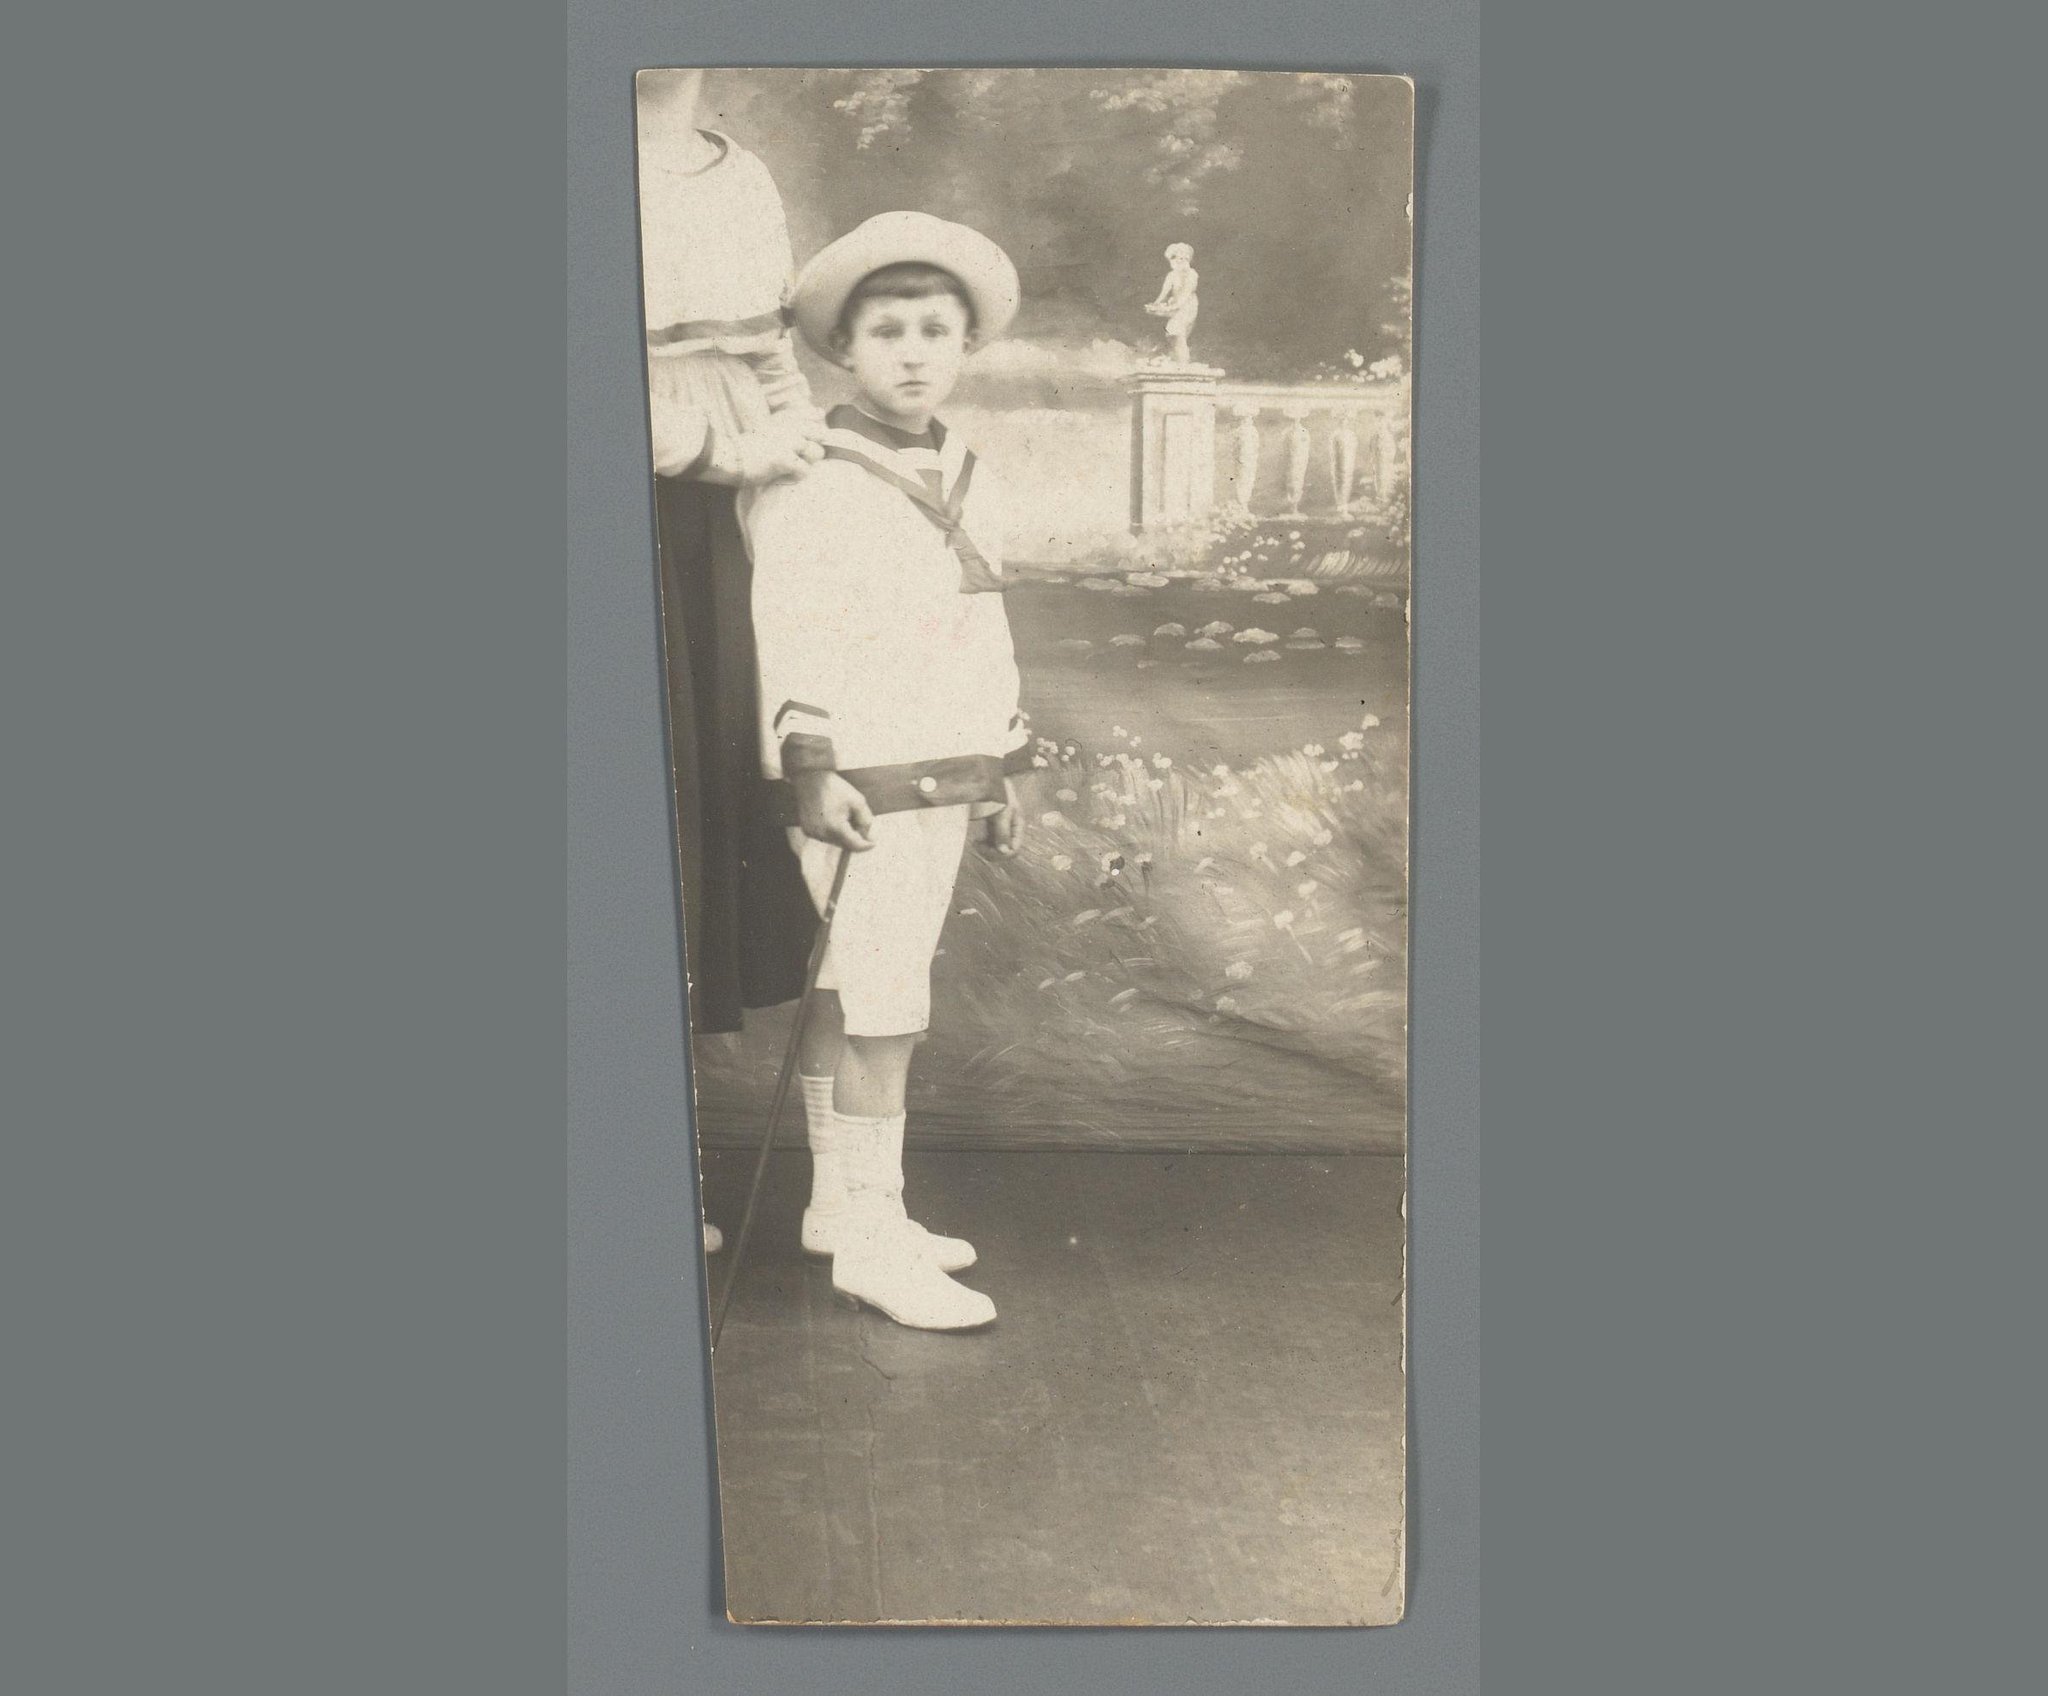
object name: photograph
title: Portret van een onbekende jongen in een fotostudio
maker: johannes cornelis bruijne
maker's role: fotograaf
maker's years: 1877-1948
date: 1905-1920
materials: paper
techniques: gelatin silver print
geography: rotterdam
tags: boy (child between toddler and youth), historical persons not known by name